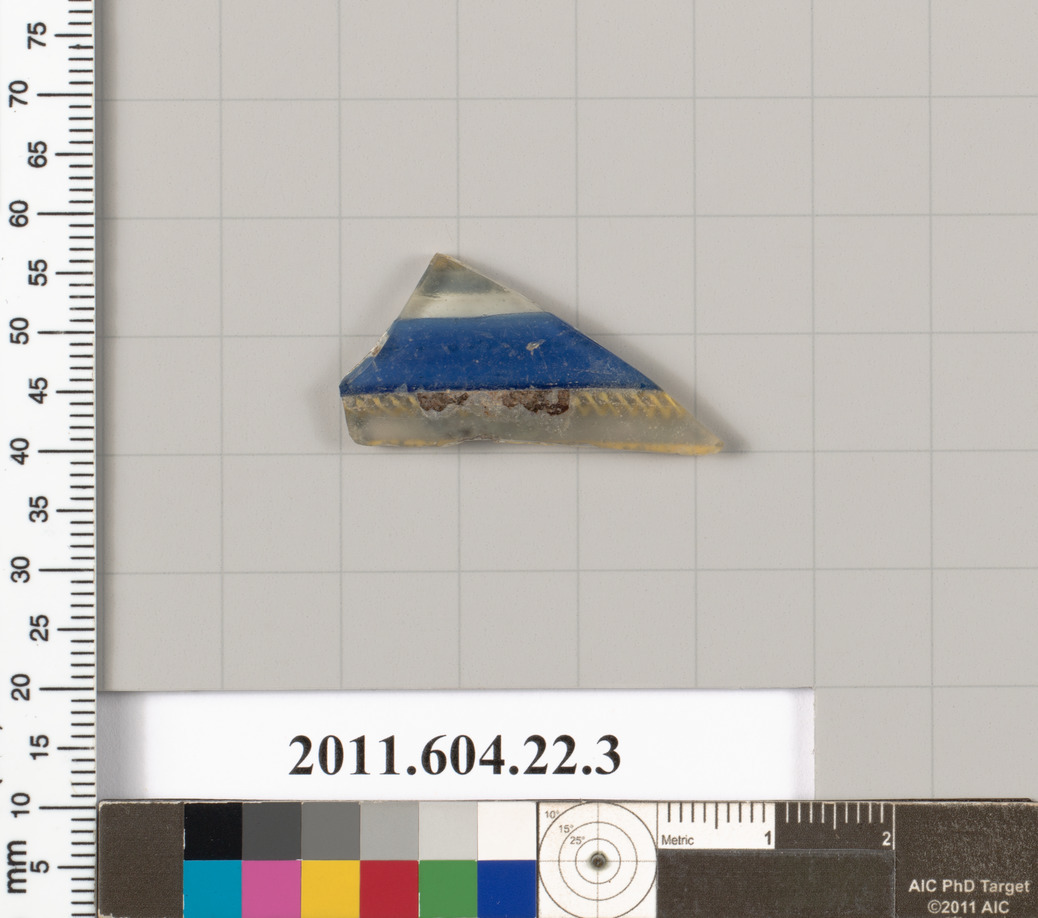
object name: glass fragment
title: Glass mosaic bowl fragment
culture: greek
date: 200-1 BCE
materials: glass